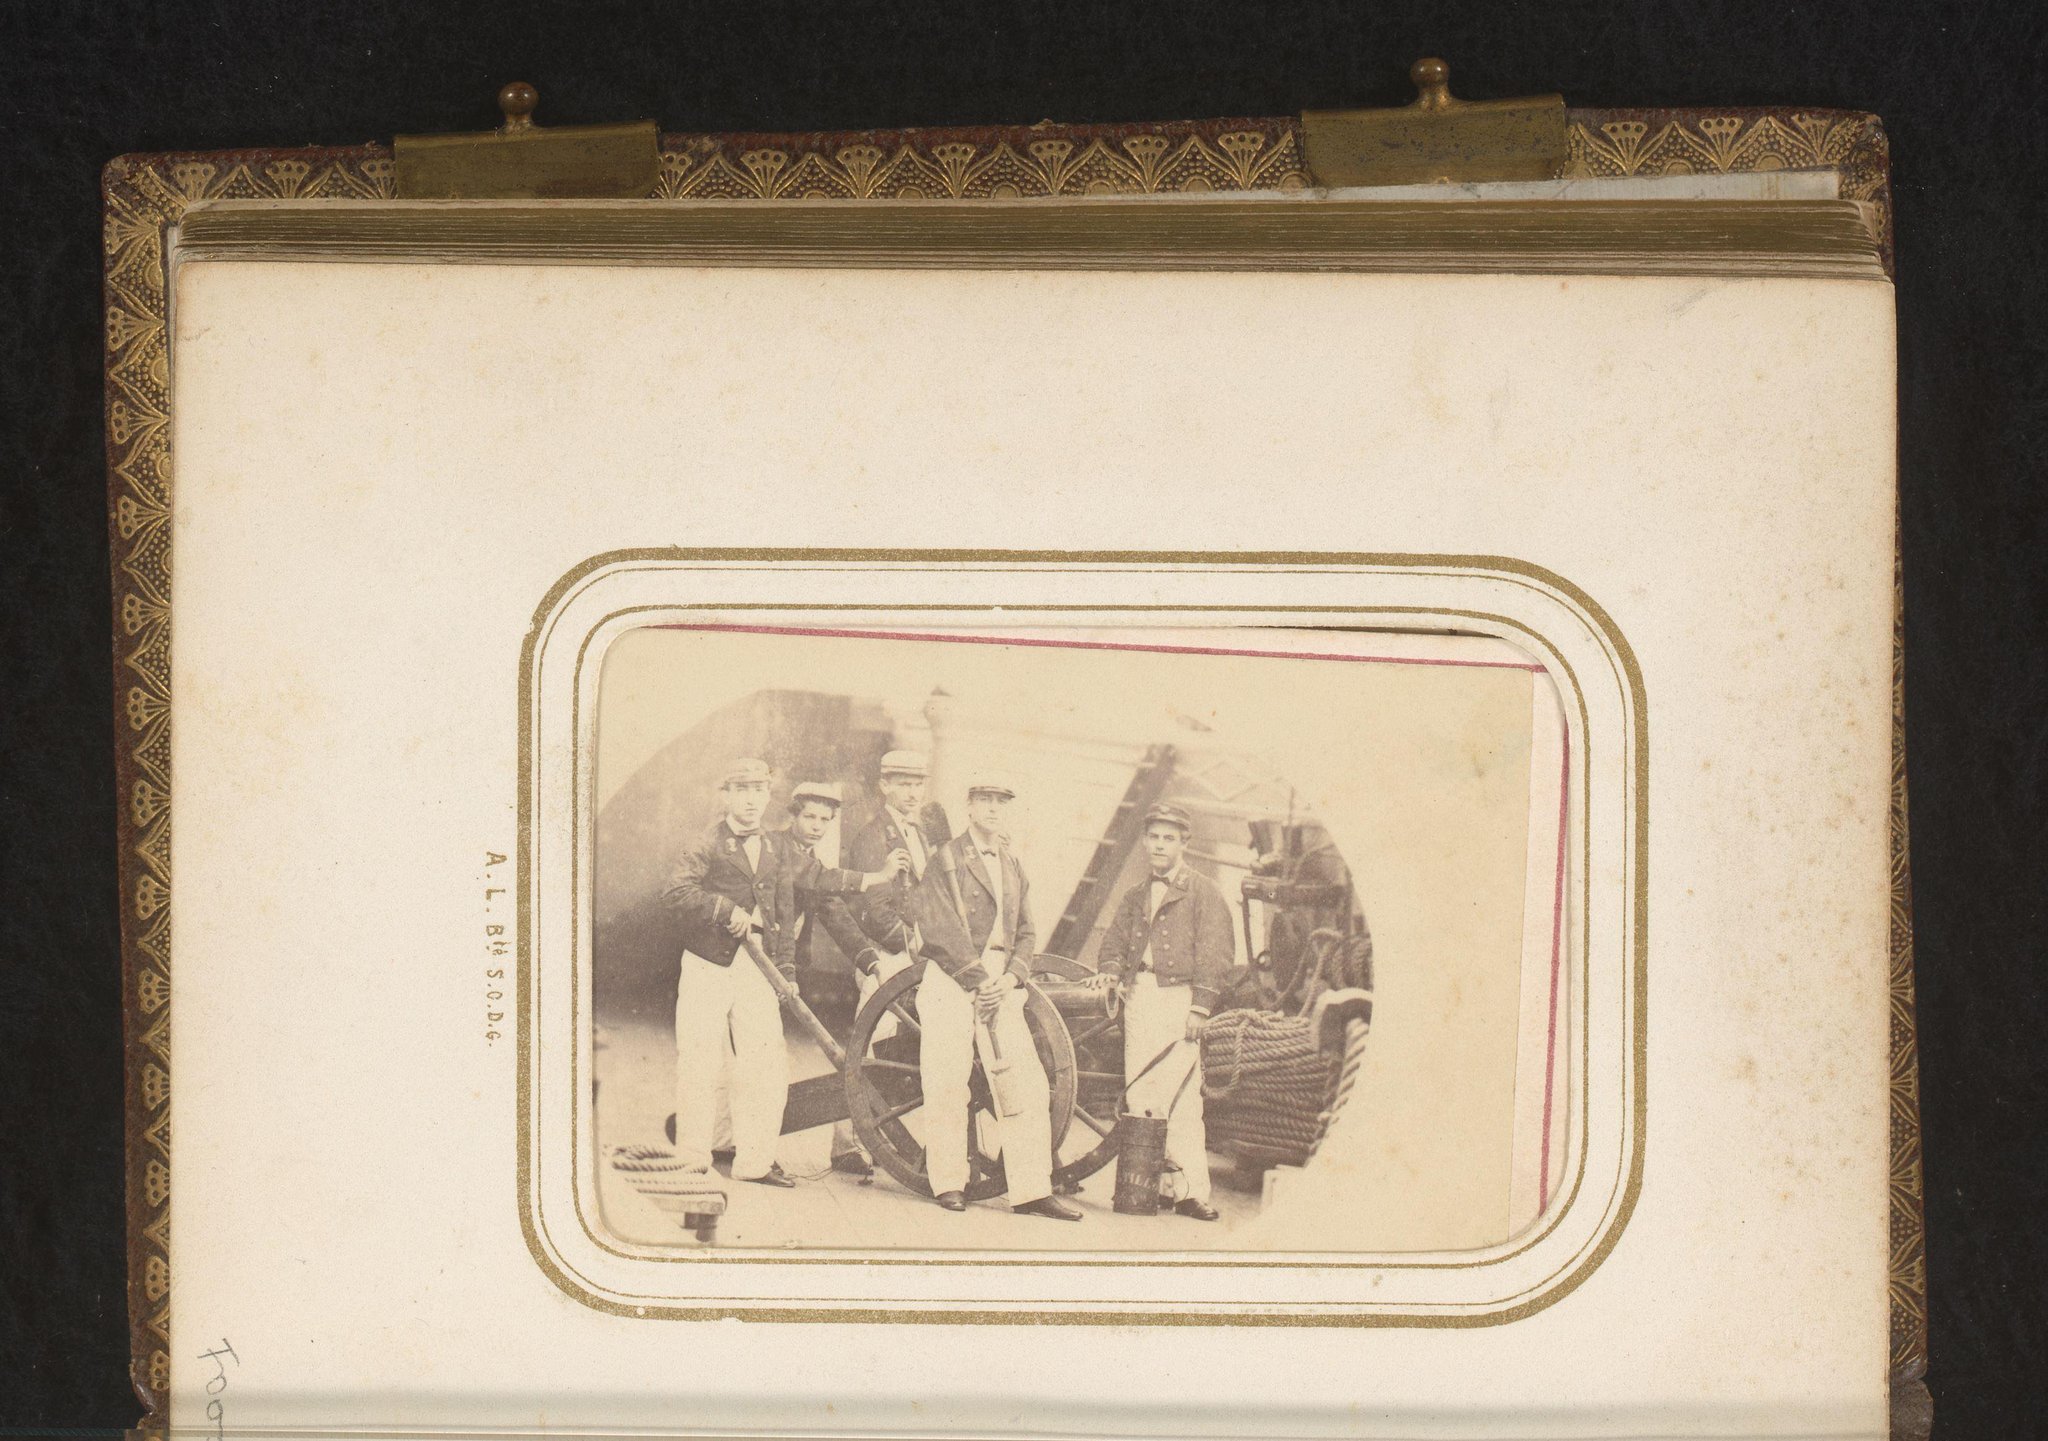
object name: carte de visite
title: Groepsportret van bemanningsleden van een schip bij een kanon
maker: Anonymous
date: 1860-1870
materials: cardboard, photographic support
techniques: albumen print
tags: historical persons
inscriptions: inscription: ‘A.L. B.te S.C.D.G.’